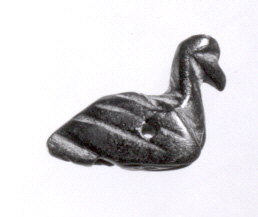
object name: stamp seal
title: Stamp seal (duck-shaped) with geometric design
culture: syro-levantine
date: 1200-601 BCE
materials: stone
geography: levant or syria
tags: ducks